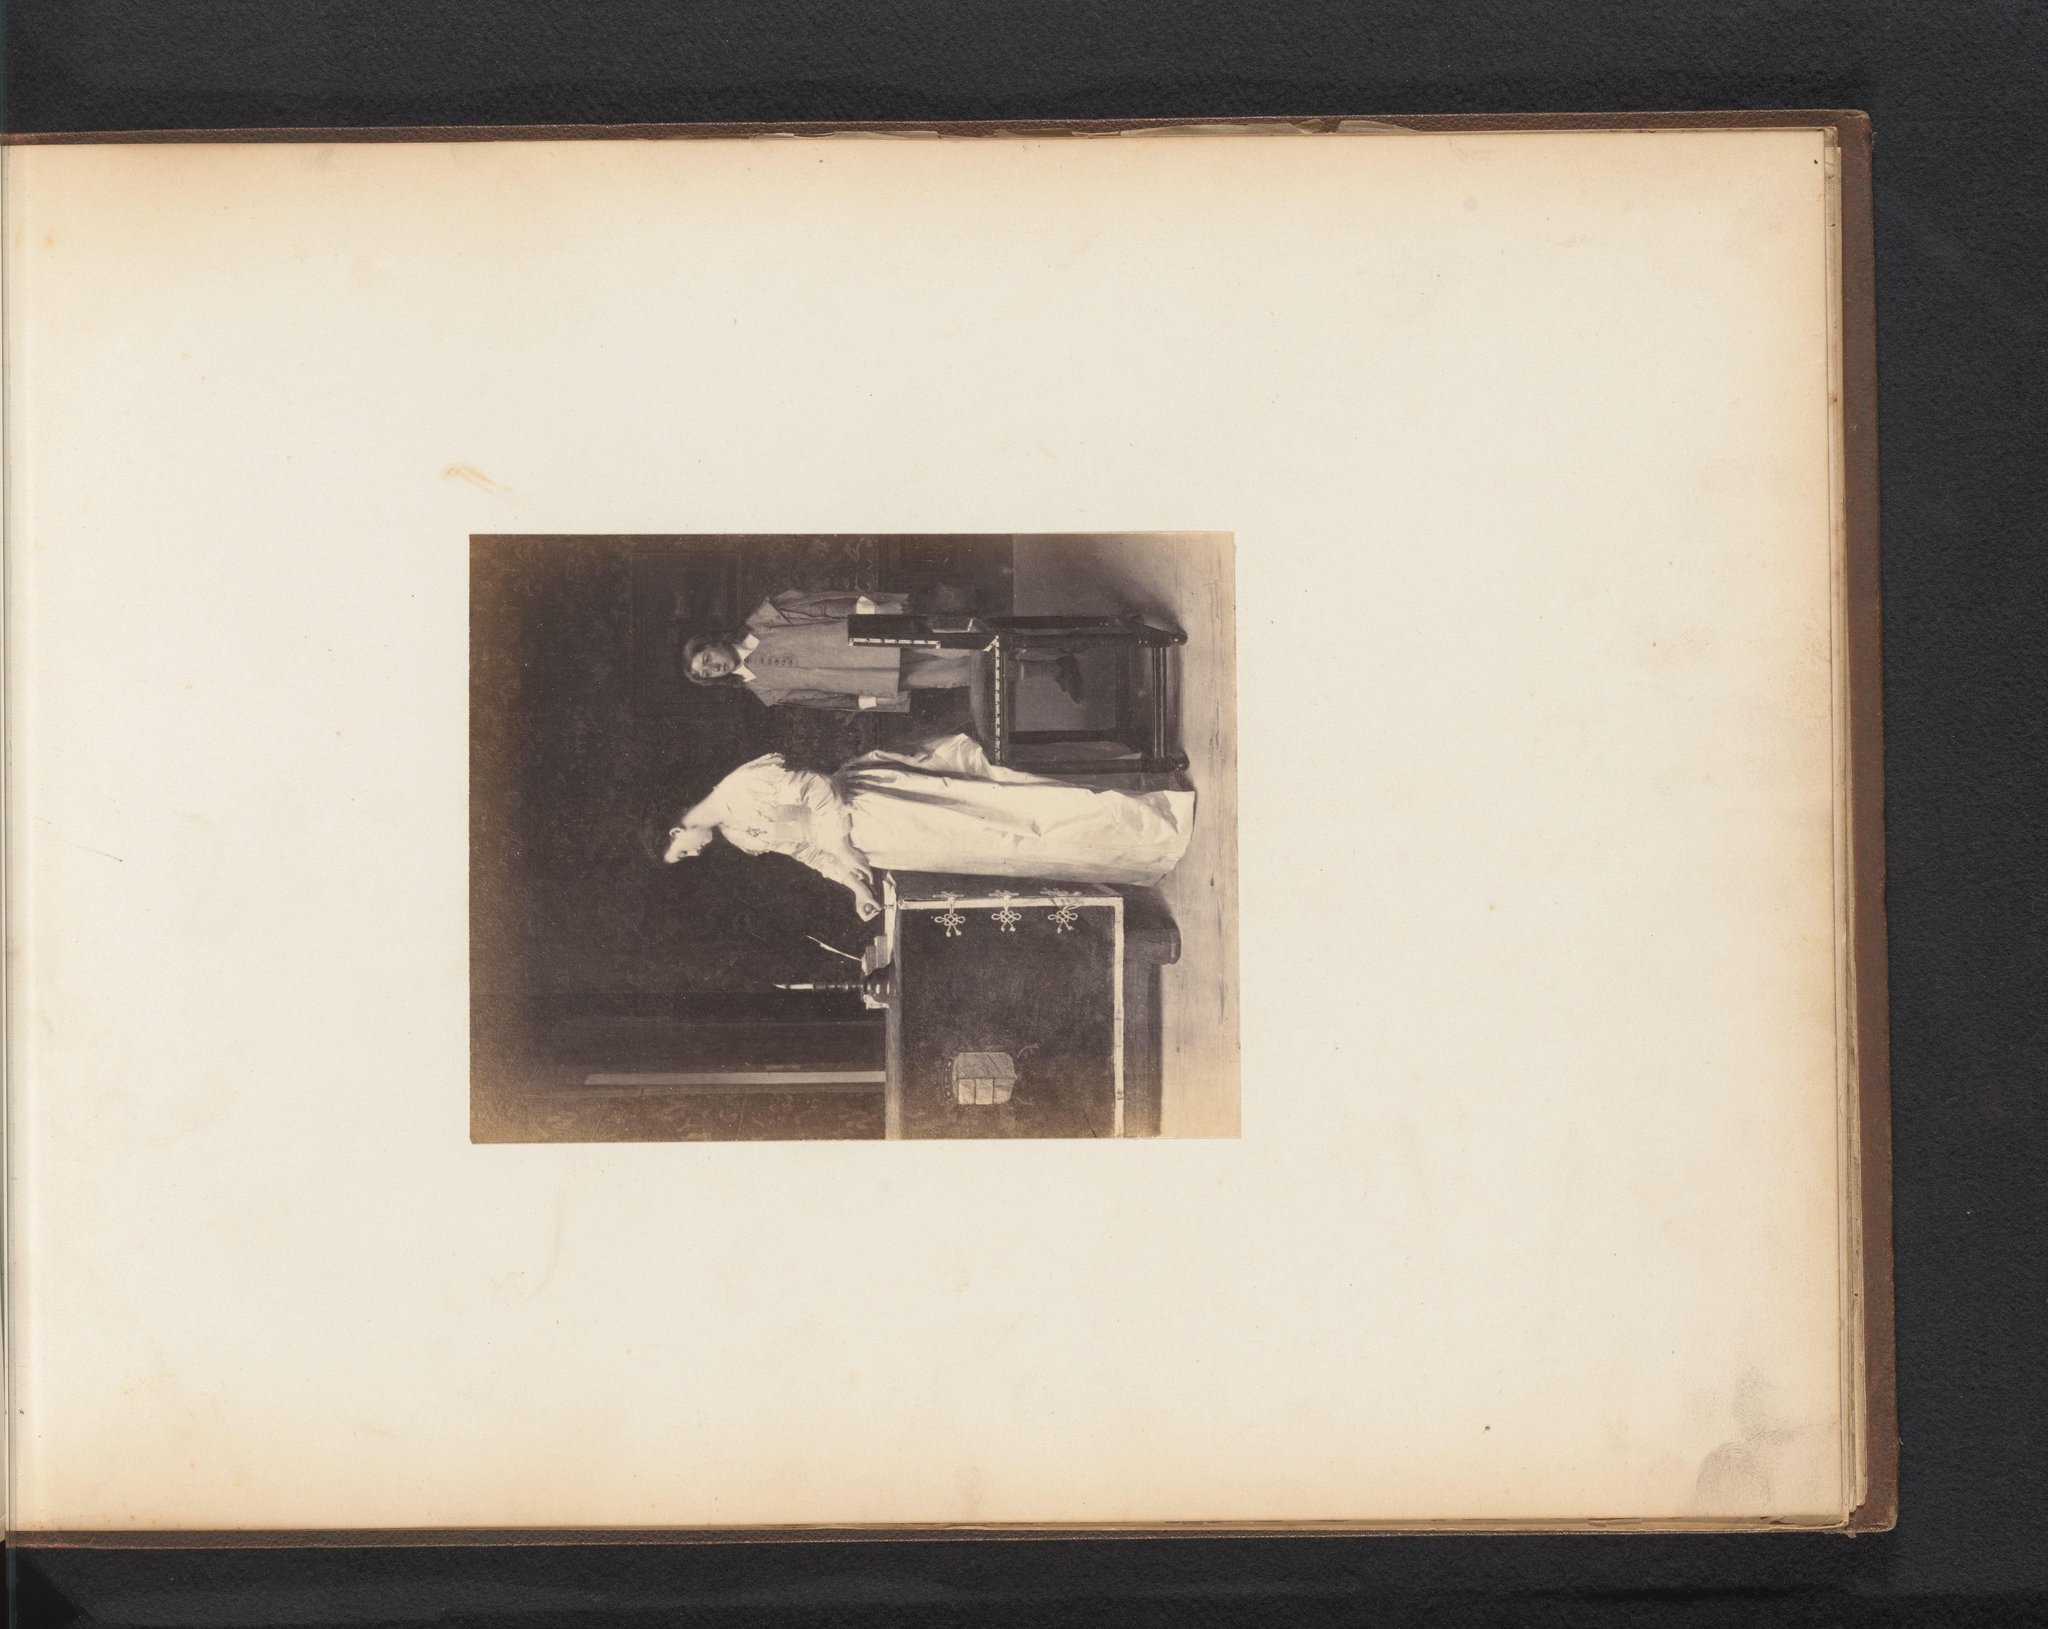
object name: photograph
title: Fotoreproductie van Le cachet van Florent Willems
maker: Anonymous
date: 1858-1863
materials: photographic support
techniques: albumen print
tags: writing-table, writing-desk, adult woman, picture, painting